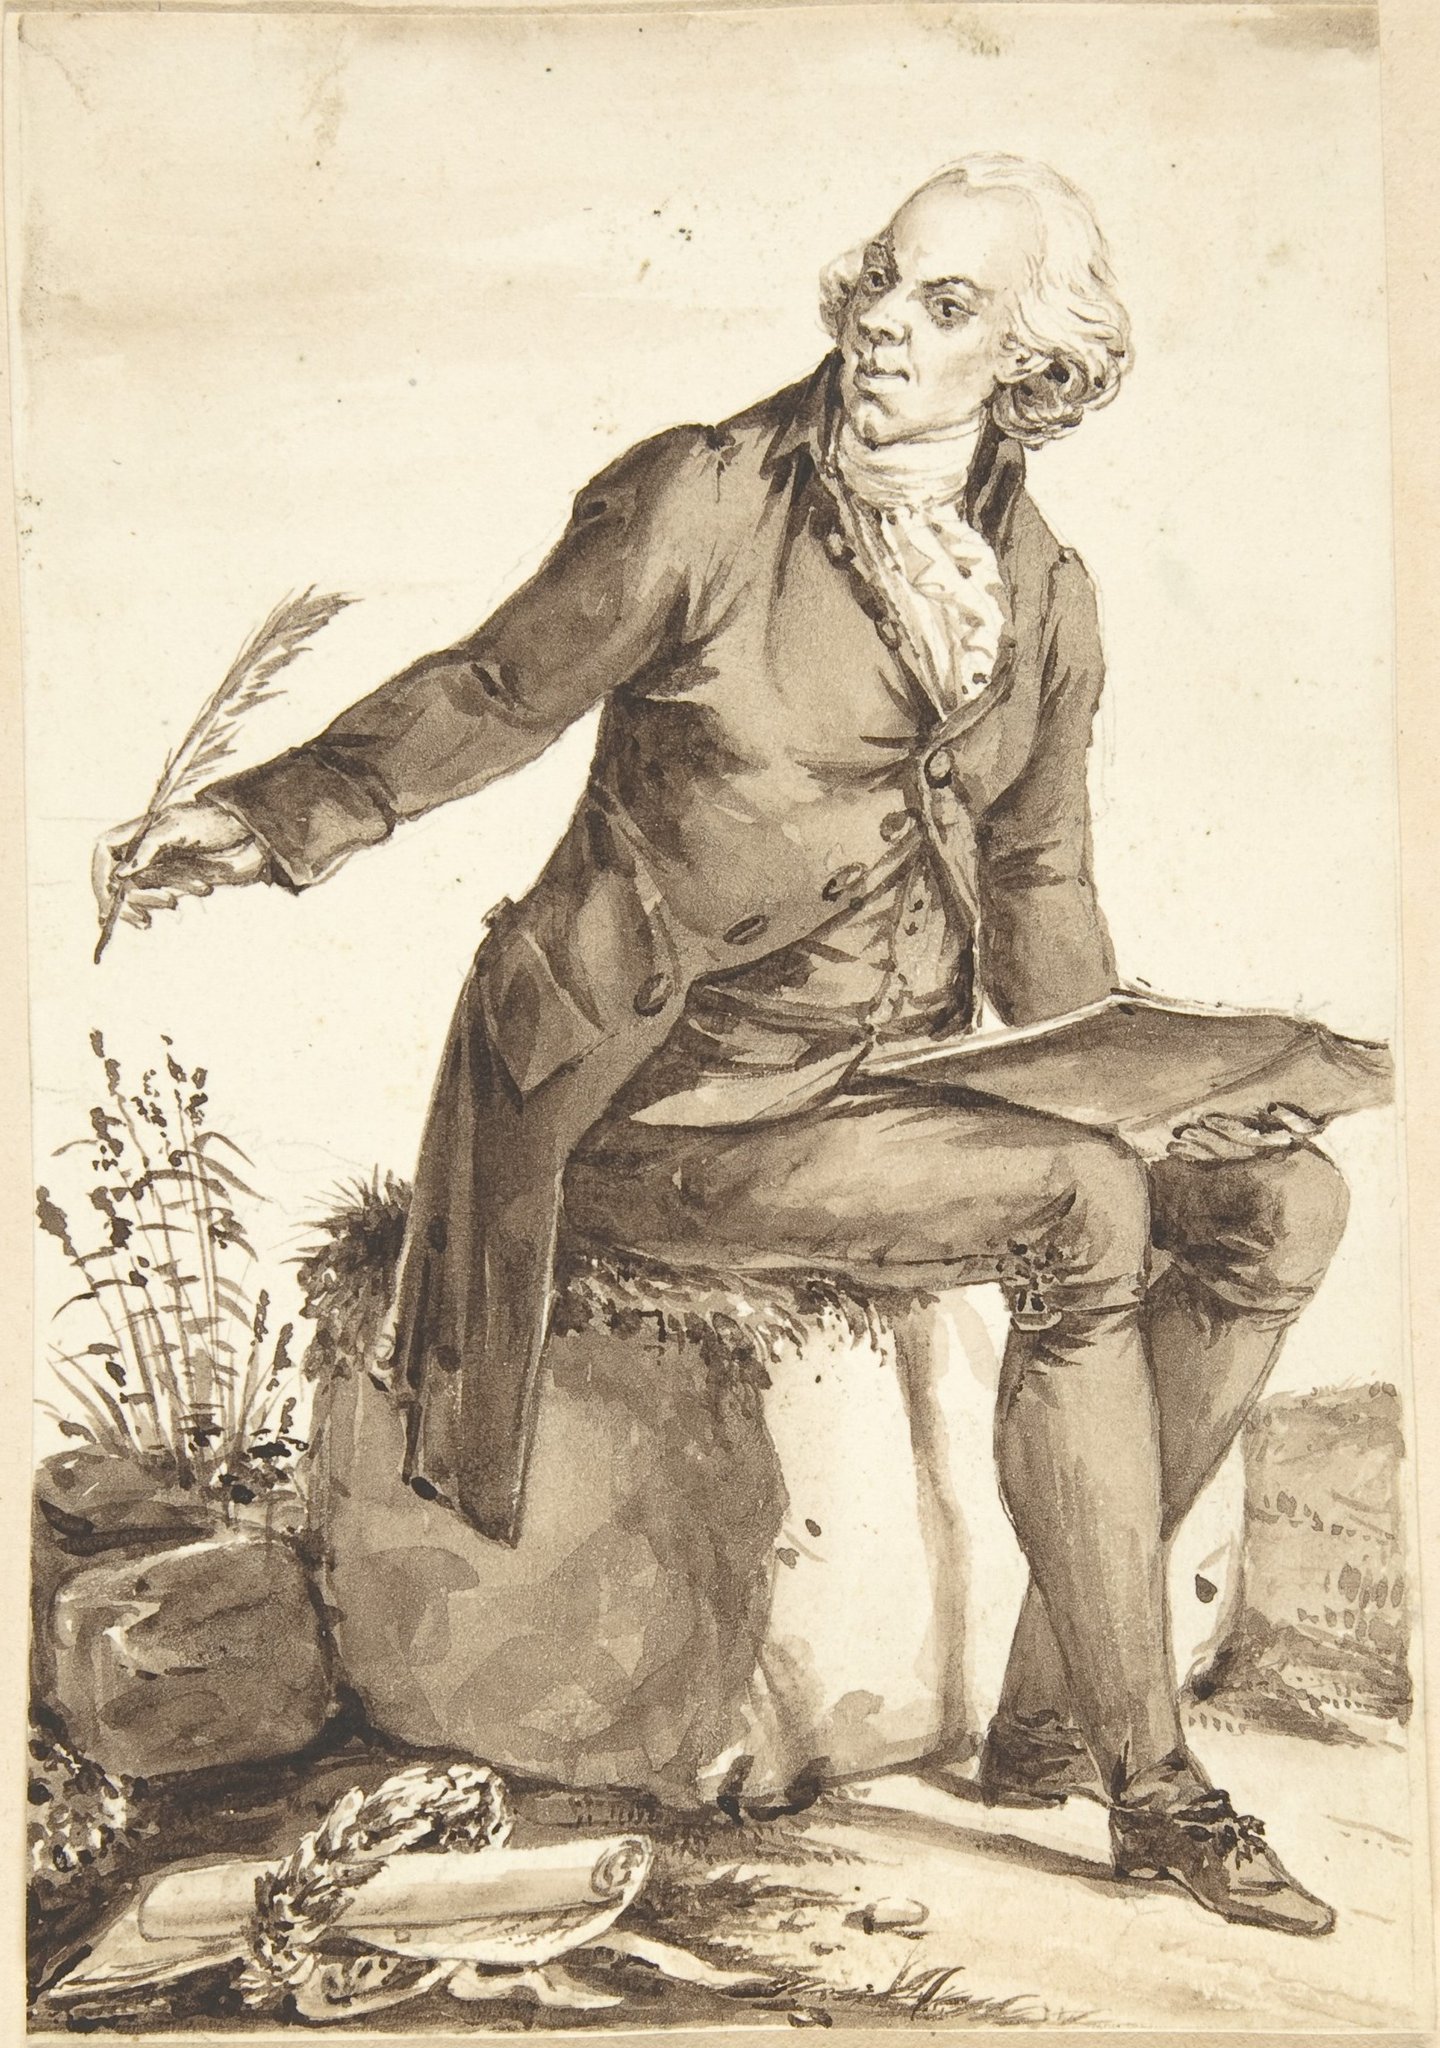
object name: drawing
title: Portrait of Jacques Delille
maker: jean-baptiste-françois bosio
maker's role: artist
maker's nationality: french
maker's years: 1764-1827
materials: graphite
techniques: brush, wash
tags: men,portraits,writing